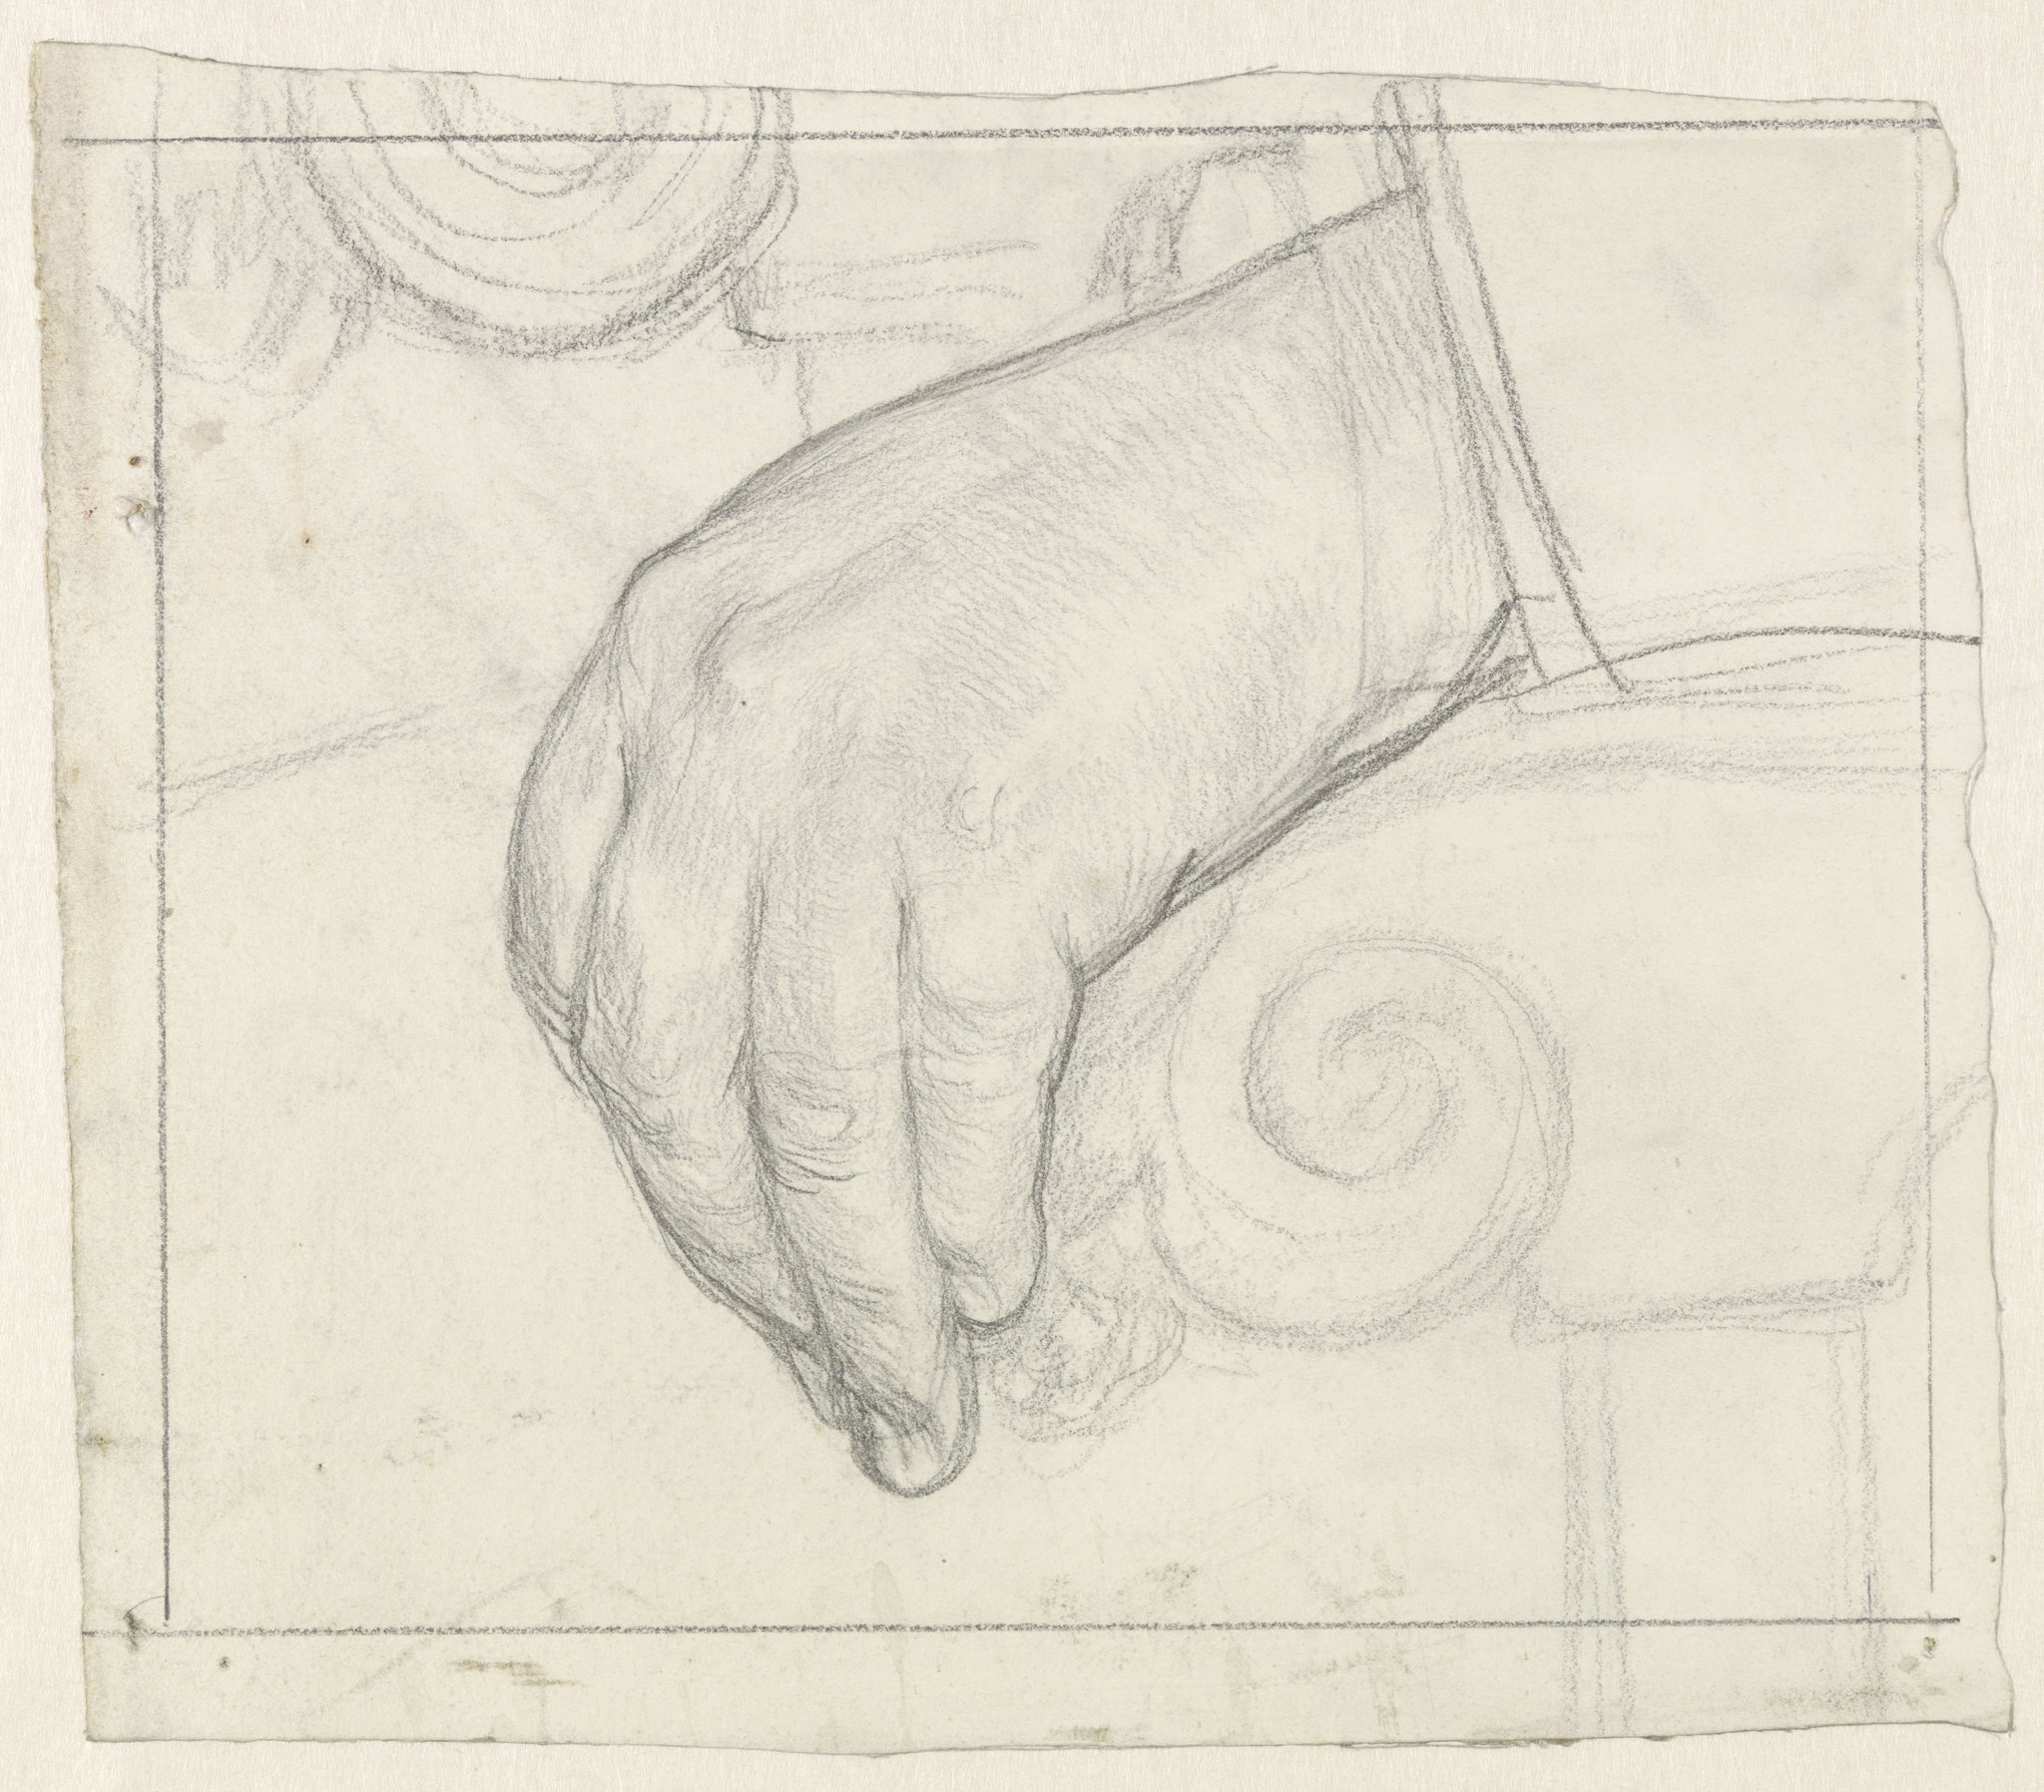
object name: drawing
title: Studie van een linkerhand op een stoelleuning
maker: jan veth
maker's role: designer, draughtsman, painter, print maker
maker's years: 1864-1925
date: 1874-1925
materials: chalk, paper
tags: hand